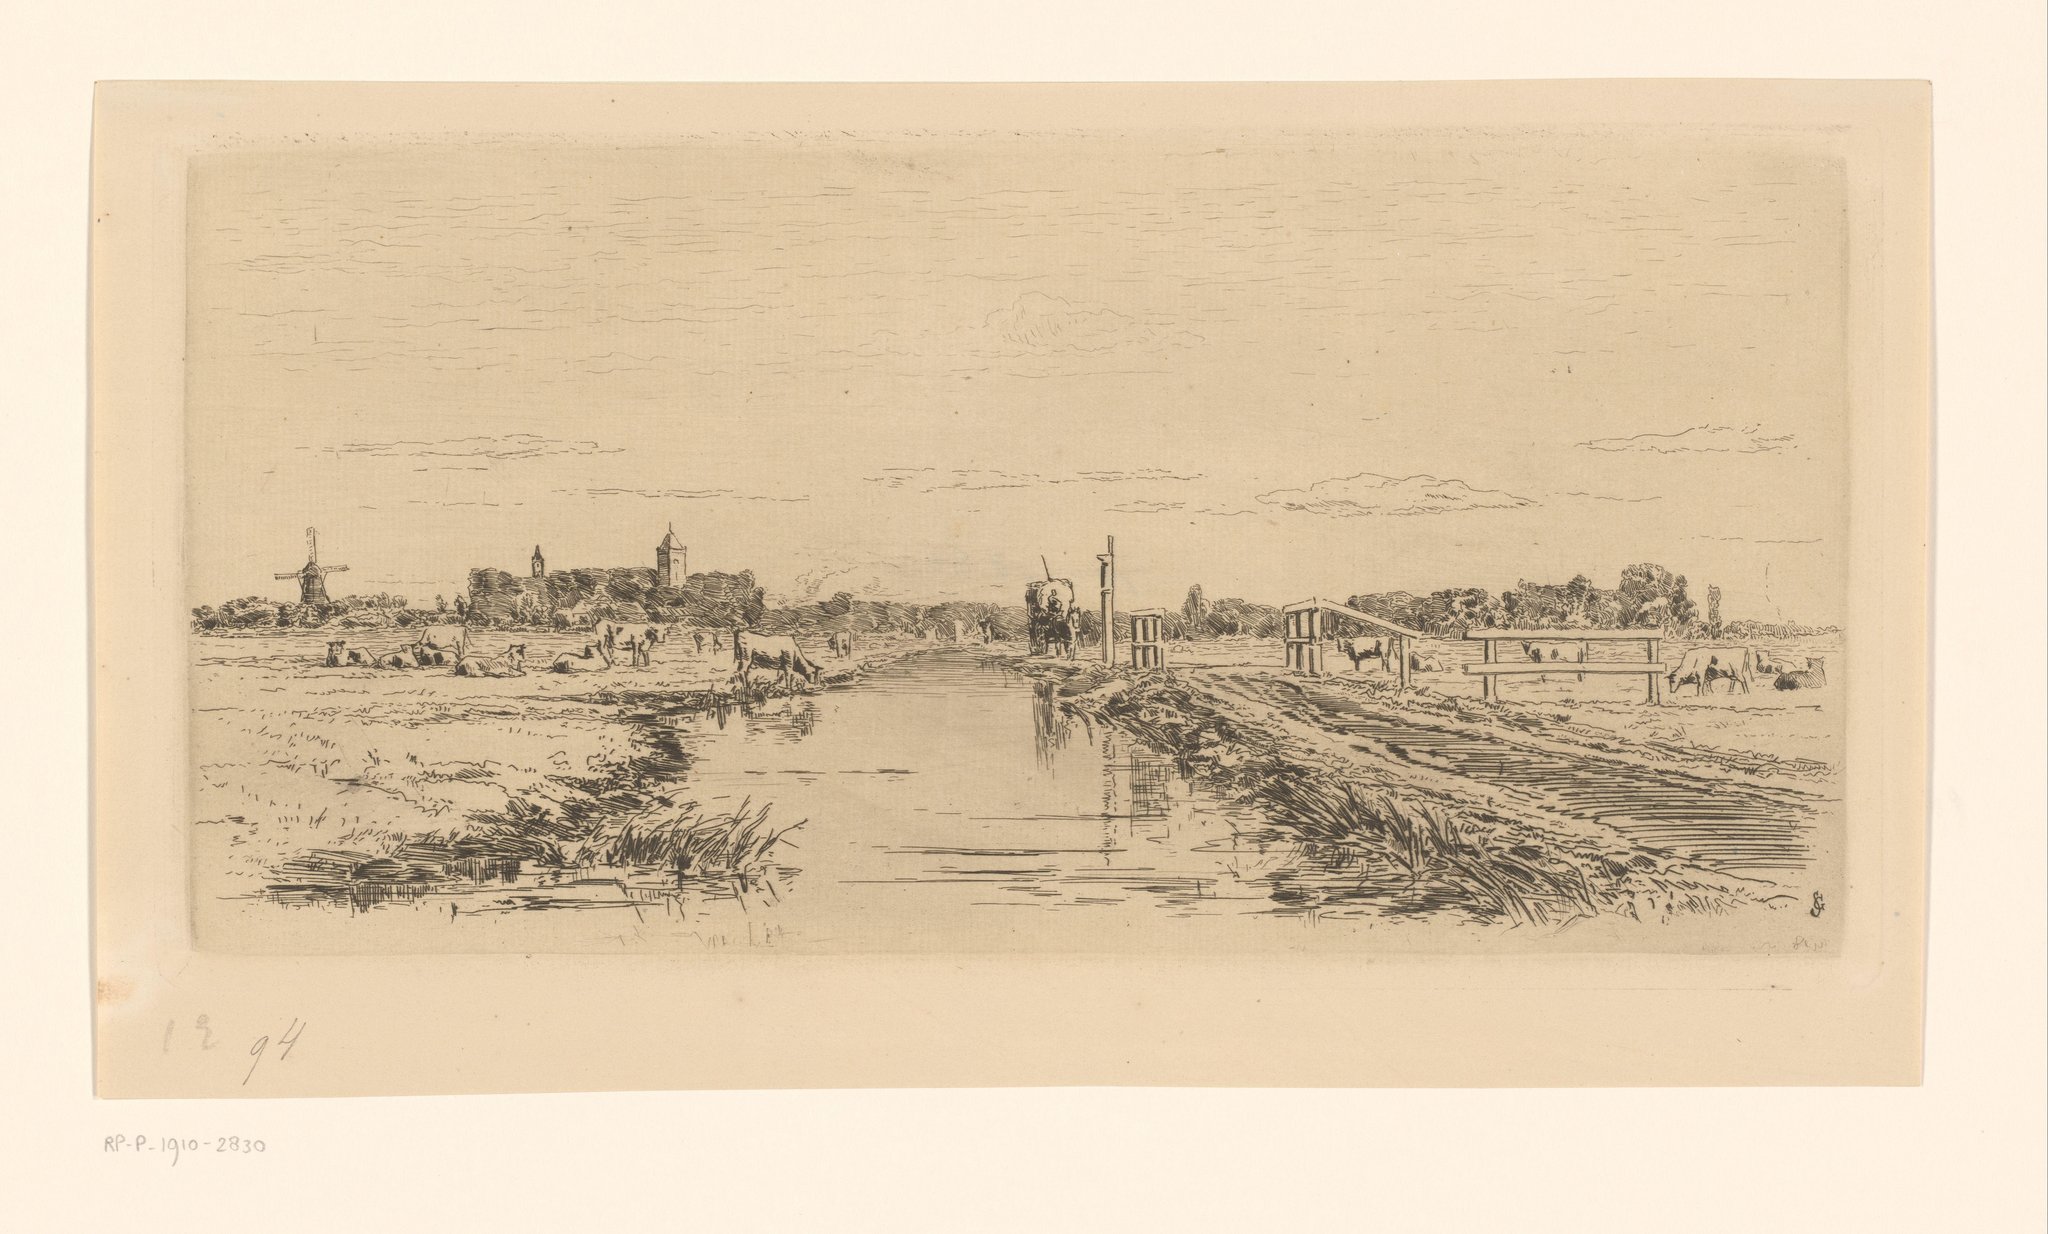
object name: print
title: Weg tussen Weesp en Muiden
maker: carel nicolaas storm van s-gravesande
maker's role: draughtsman, print maker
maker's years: 1841-1924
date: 1877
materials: paper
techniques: etching, intaglio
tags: river, road, path, bovine cattle, vecht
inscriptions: collector's mark: Lugt 2228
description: Landschap met in het midden een weg naast een rivier, mogelijk de Vecht. Op de weg rijdt een paard-en-wagen. Op de oever grazende koeien. Aan de horizon zijn een kerktoren en een molen te zien.